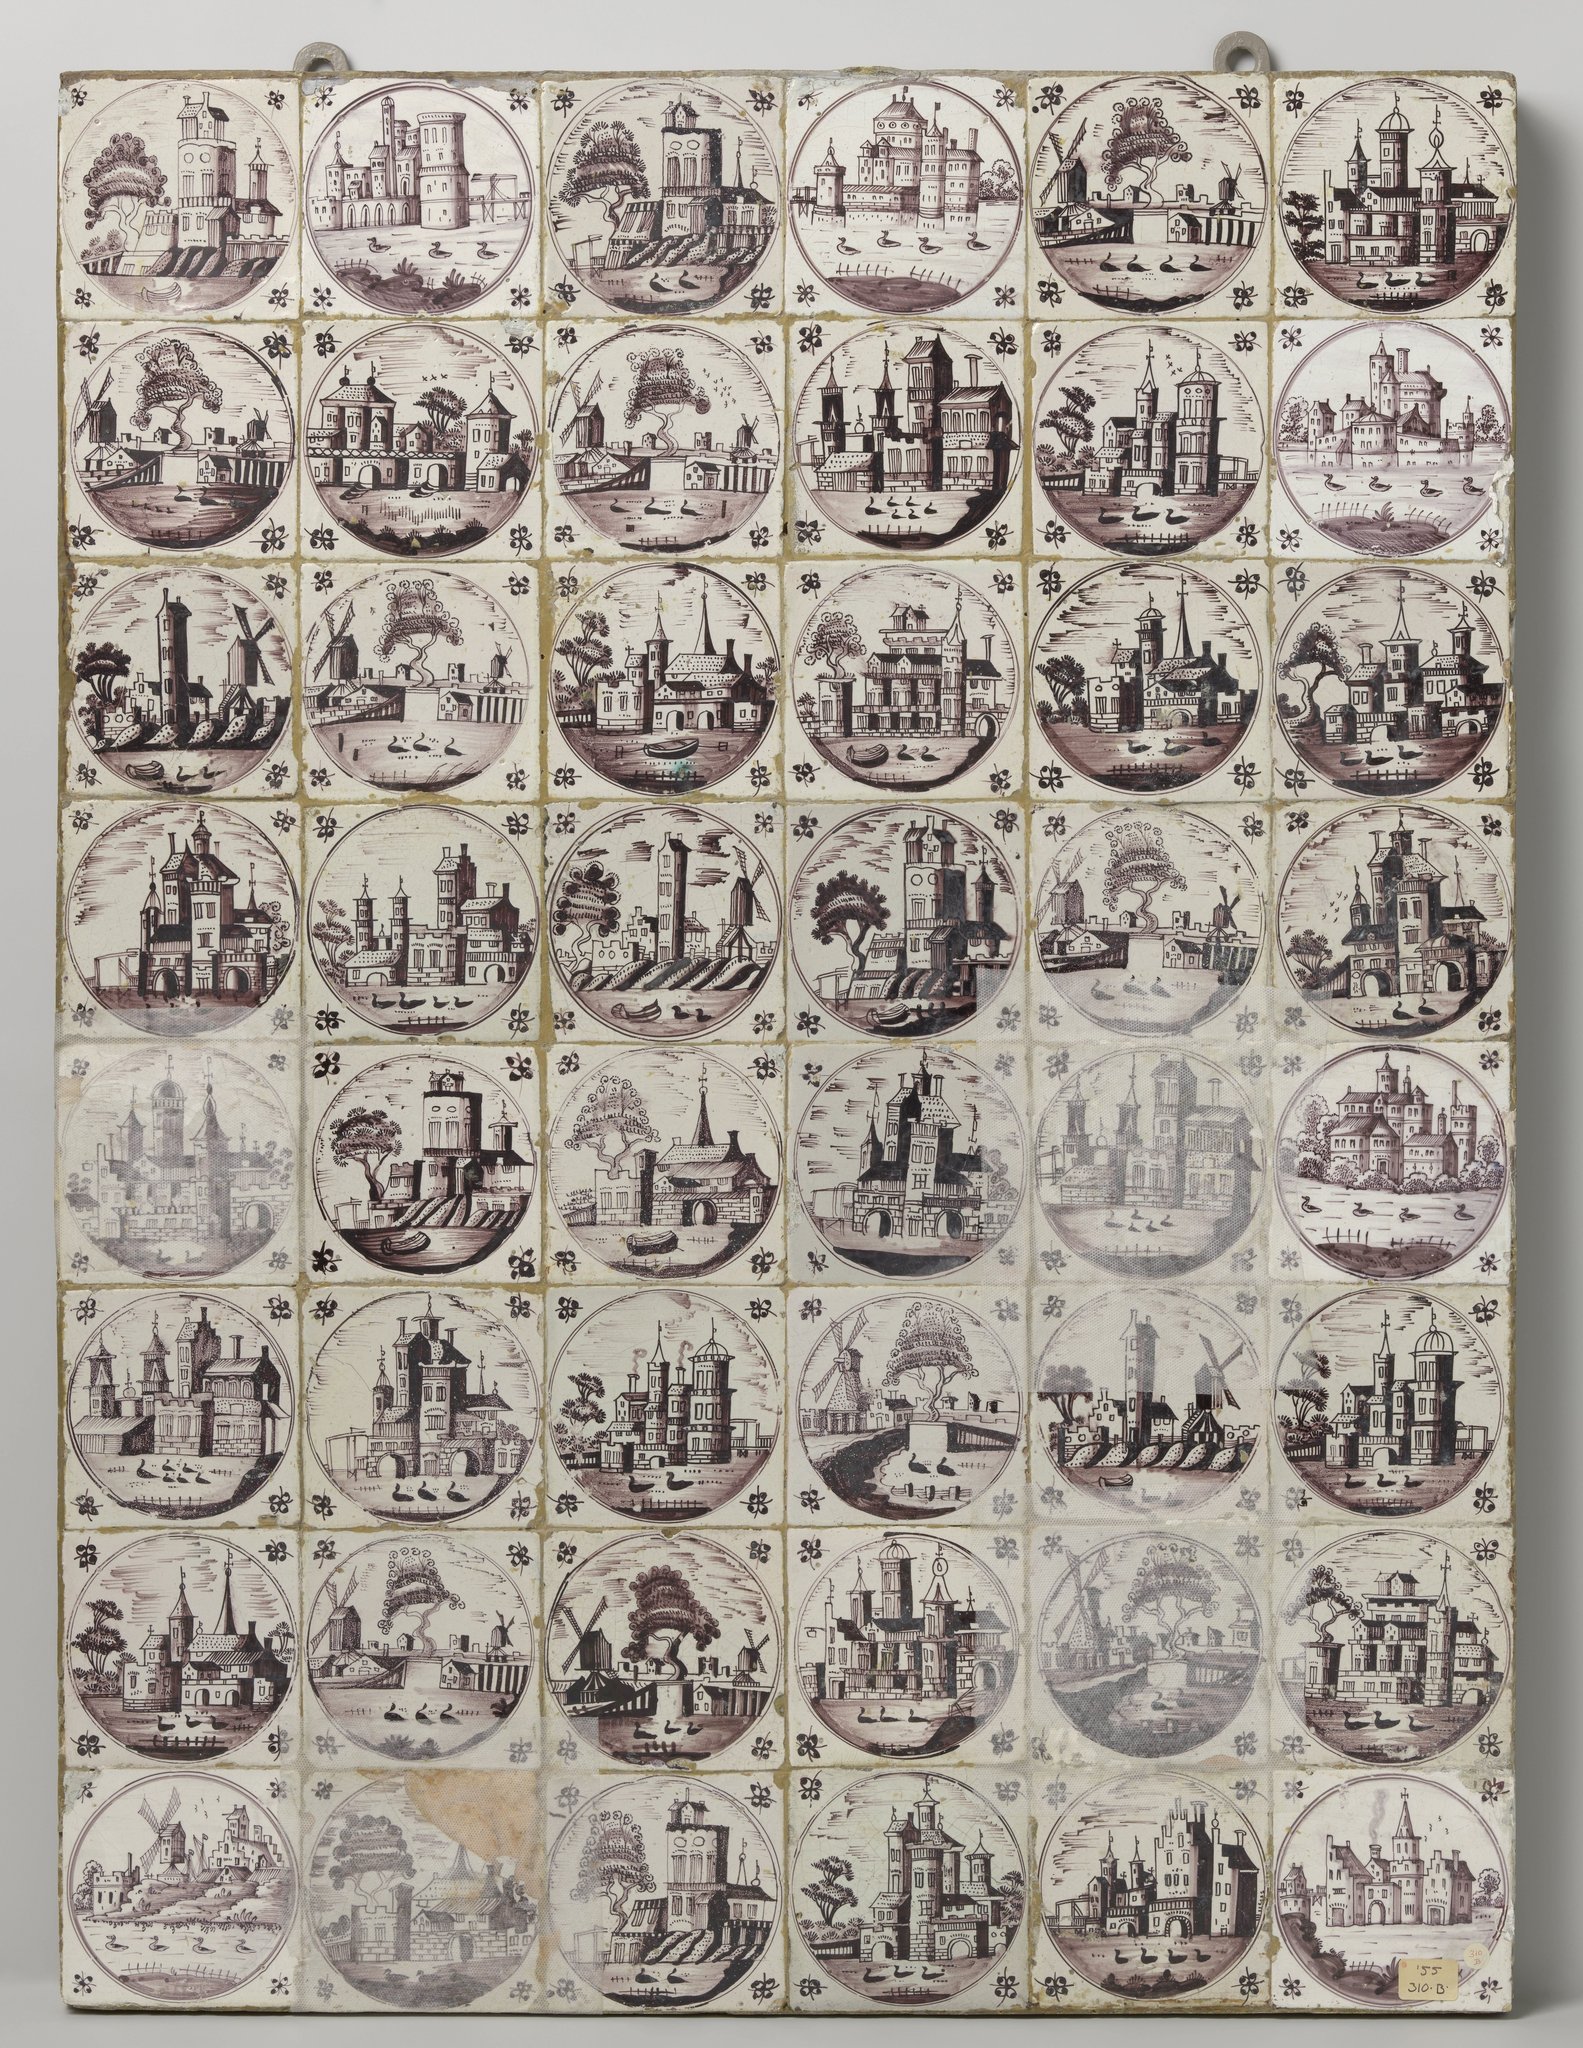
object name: landschaptegel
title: Veld van achtenveertig tegels met landschappen en kastelen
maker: Anonymous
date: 1660-1690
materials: earthenware, glaze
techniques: maiolica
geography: harlingen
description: Veld van achtenveertig tegels (8 x 6) elk met een blauw geschilderd landschap met een kasteel binnen een cirkel. In de hoeken, een spinnetje.